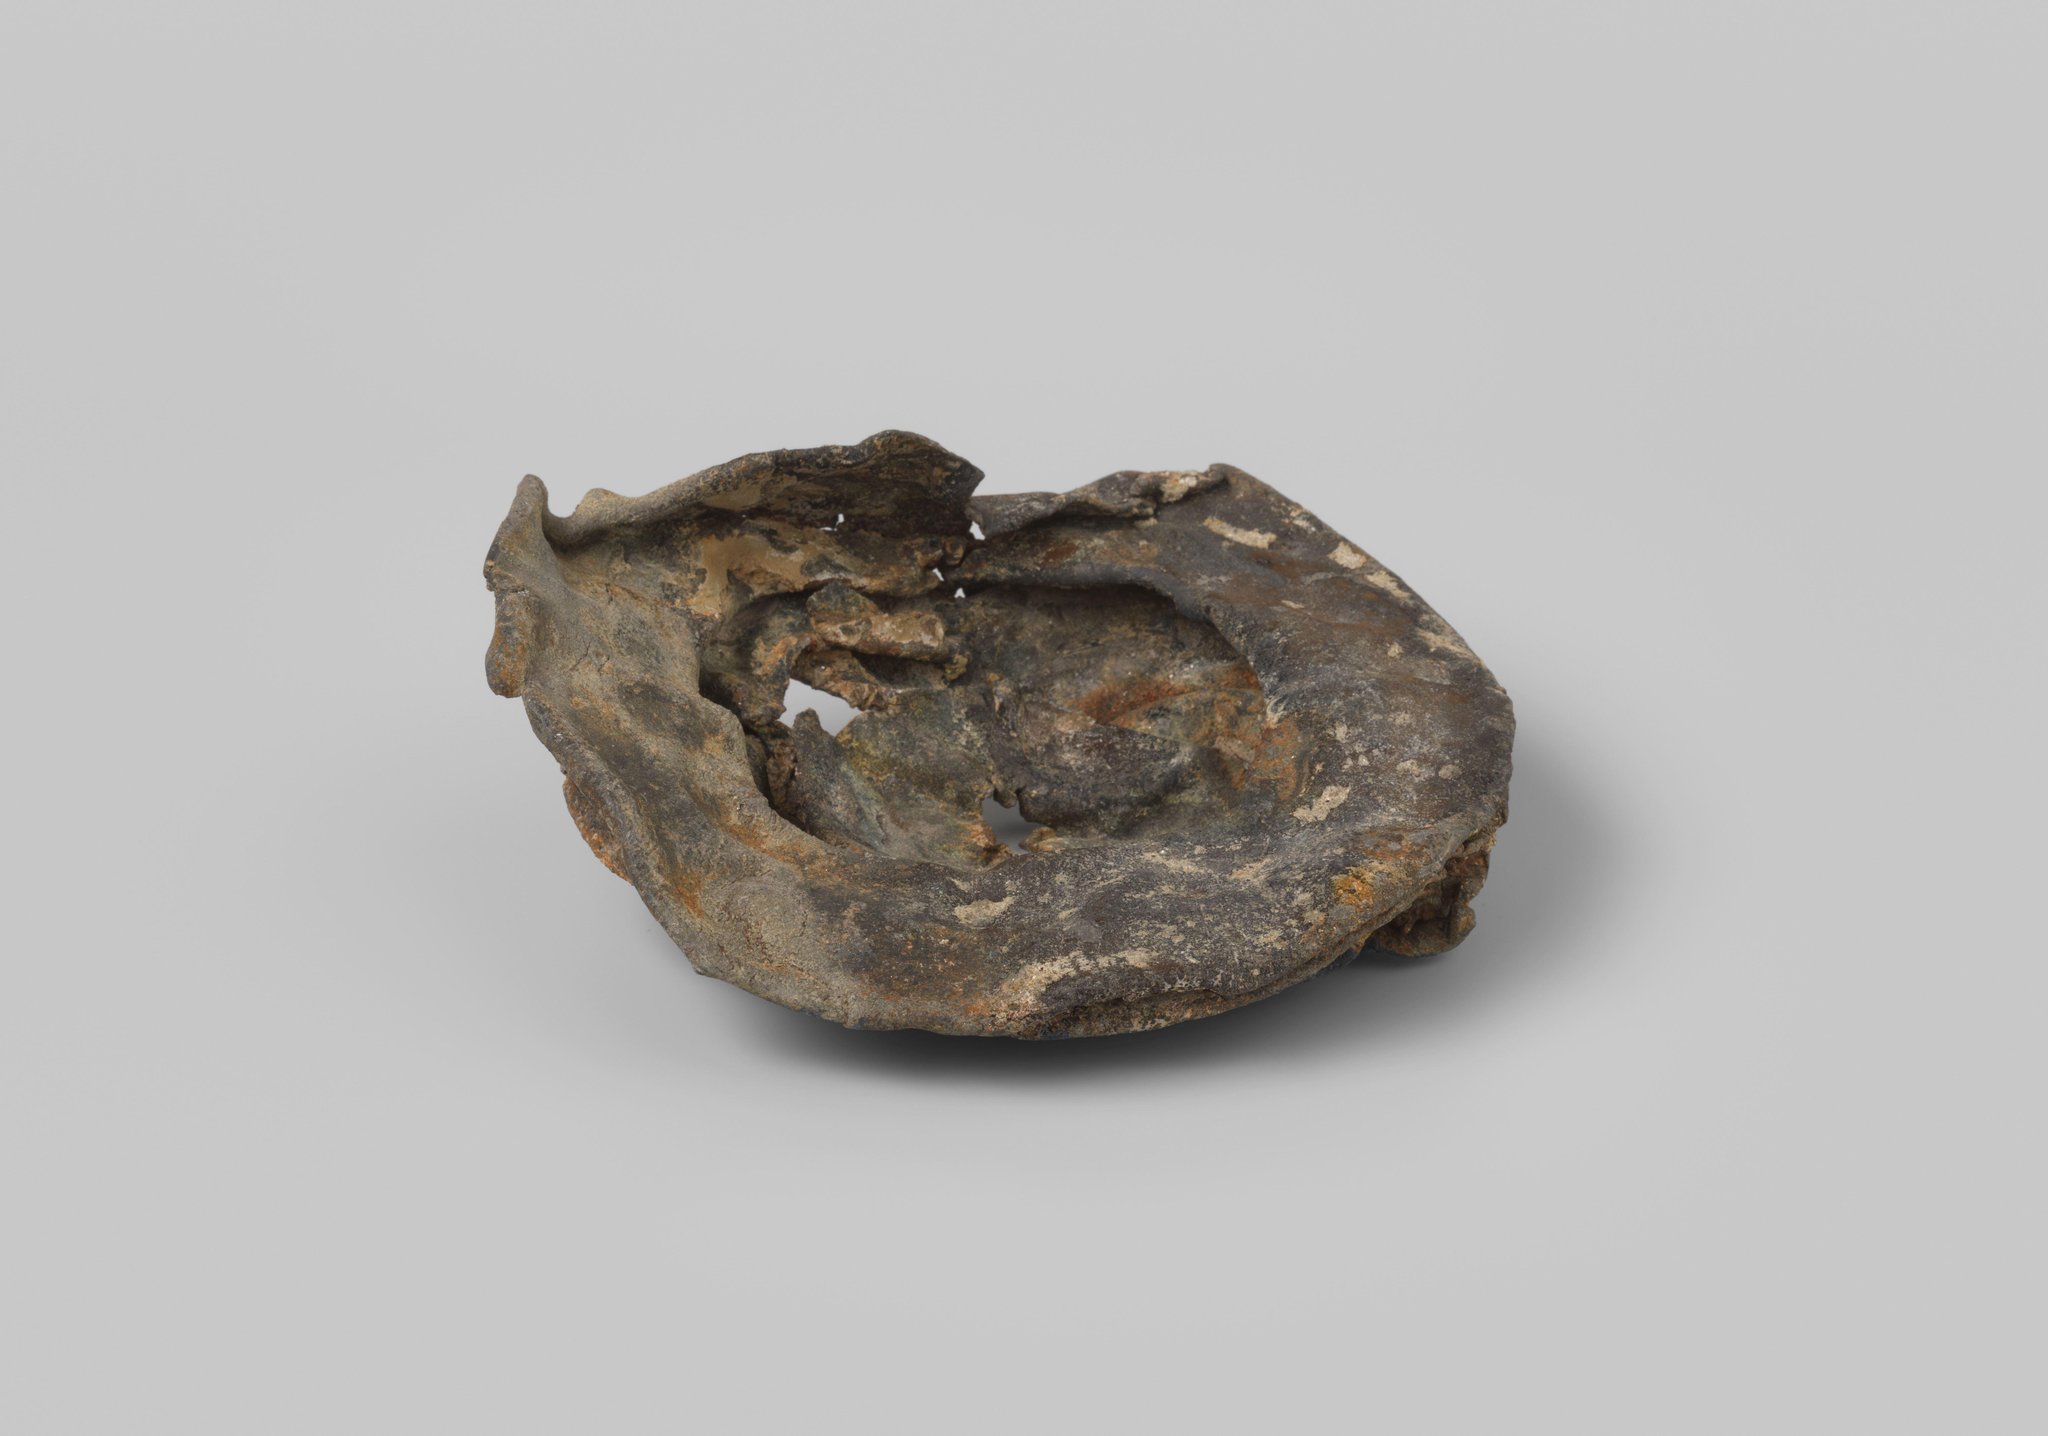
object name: chamber pot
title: Po uit het wrak van de Oost-Indiëvaarder Hollandia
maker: Anonymous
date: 1700-1743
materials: tin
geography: netherlands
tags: verenigde oostindische compagnie, hollandia (schip), annet